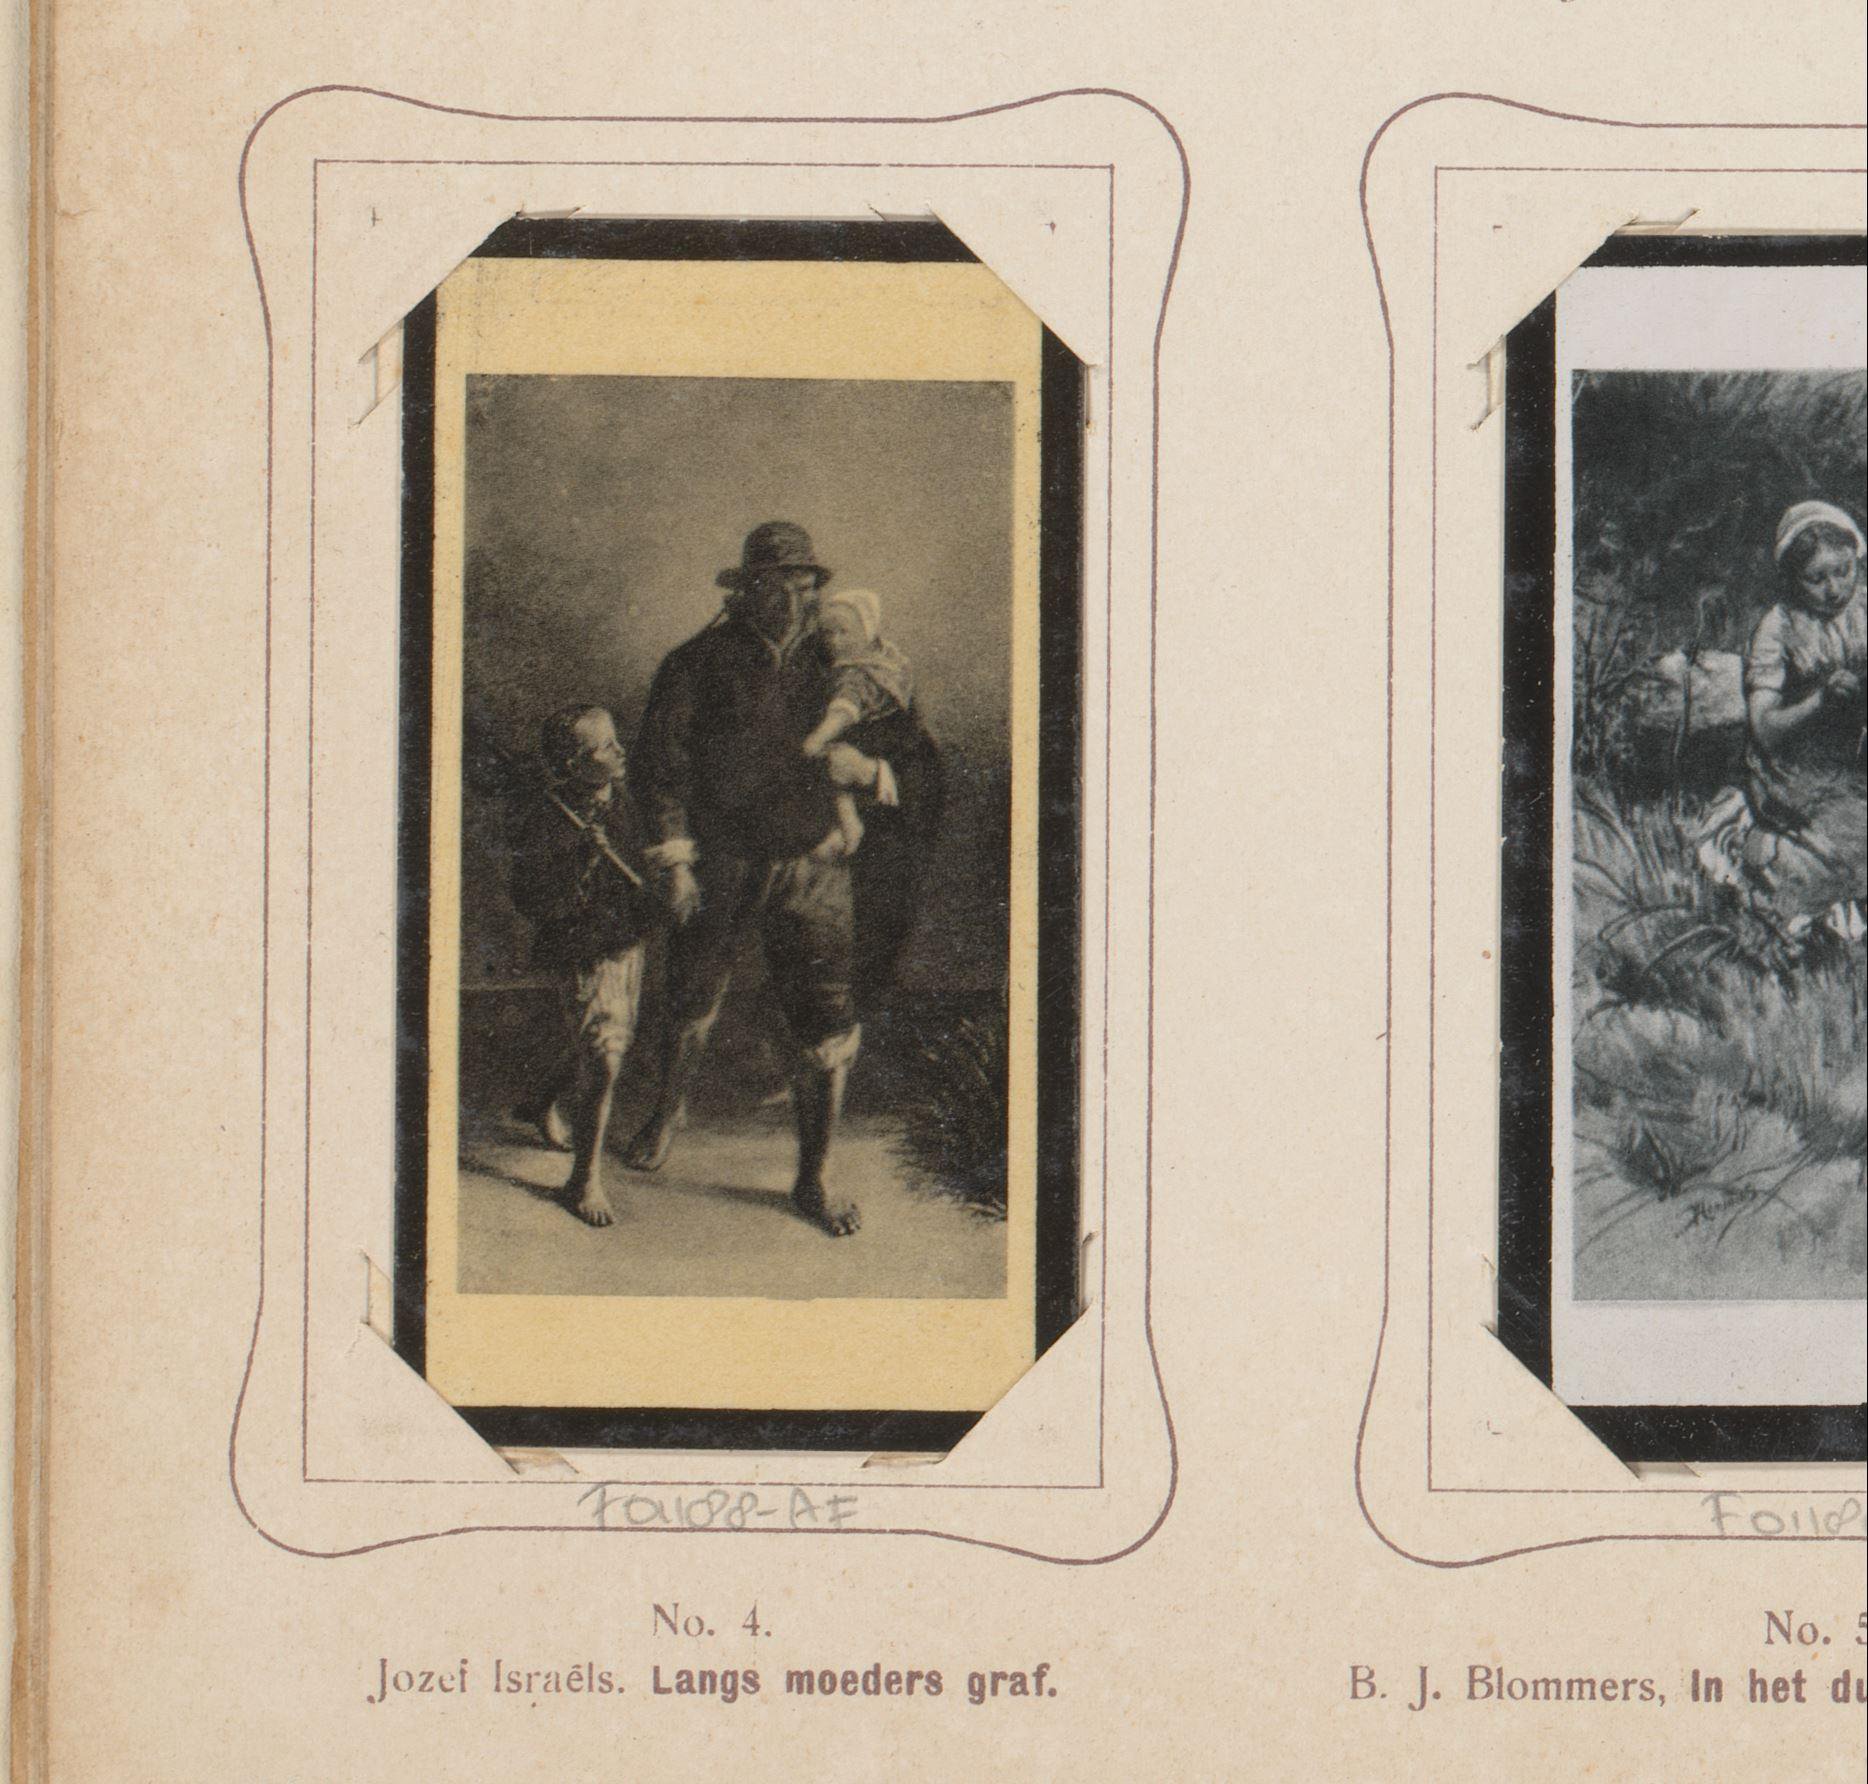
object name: album leaf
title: Reproductie van een schilderij van een vader met twee kinderen naar Jozef Israëls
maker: Anonymous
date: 1906-1907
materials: paper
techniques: photograph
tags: father and child(ren), man and child(ren) (family group)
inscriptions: inscription: ‘No. 4./ Jozef Israëls. Langs moeders graf.’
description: Deze prent maakt deel uit van een album.